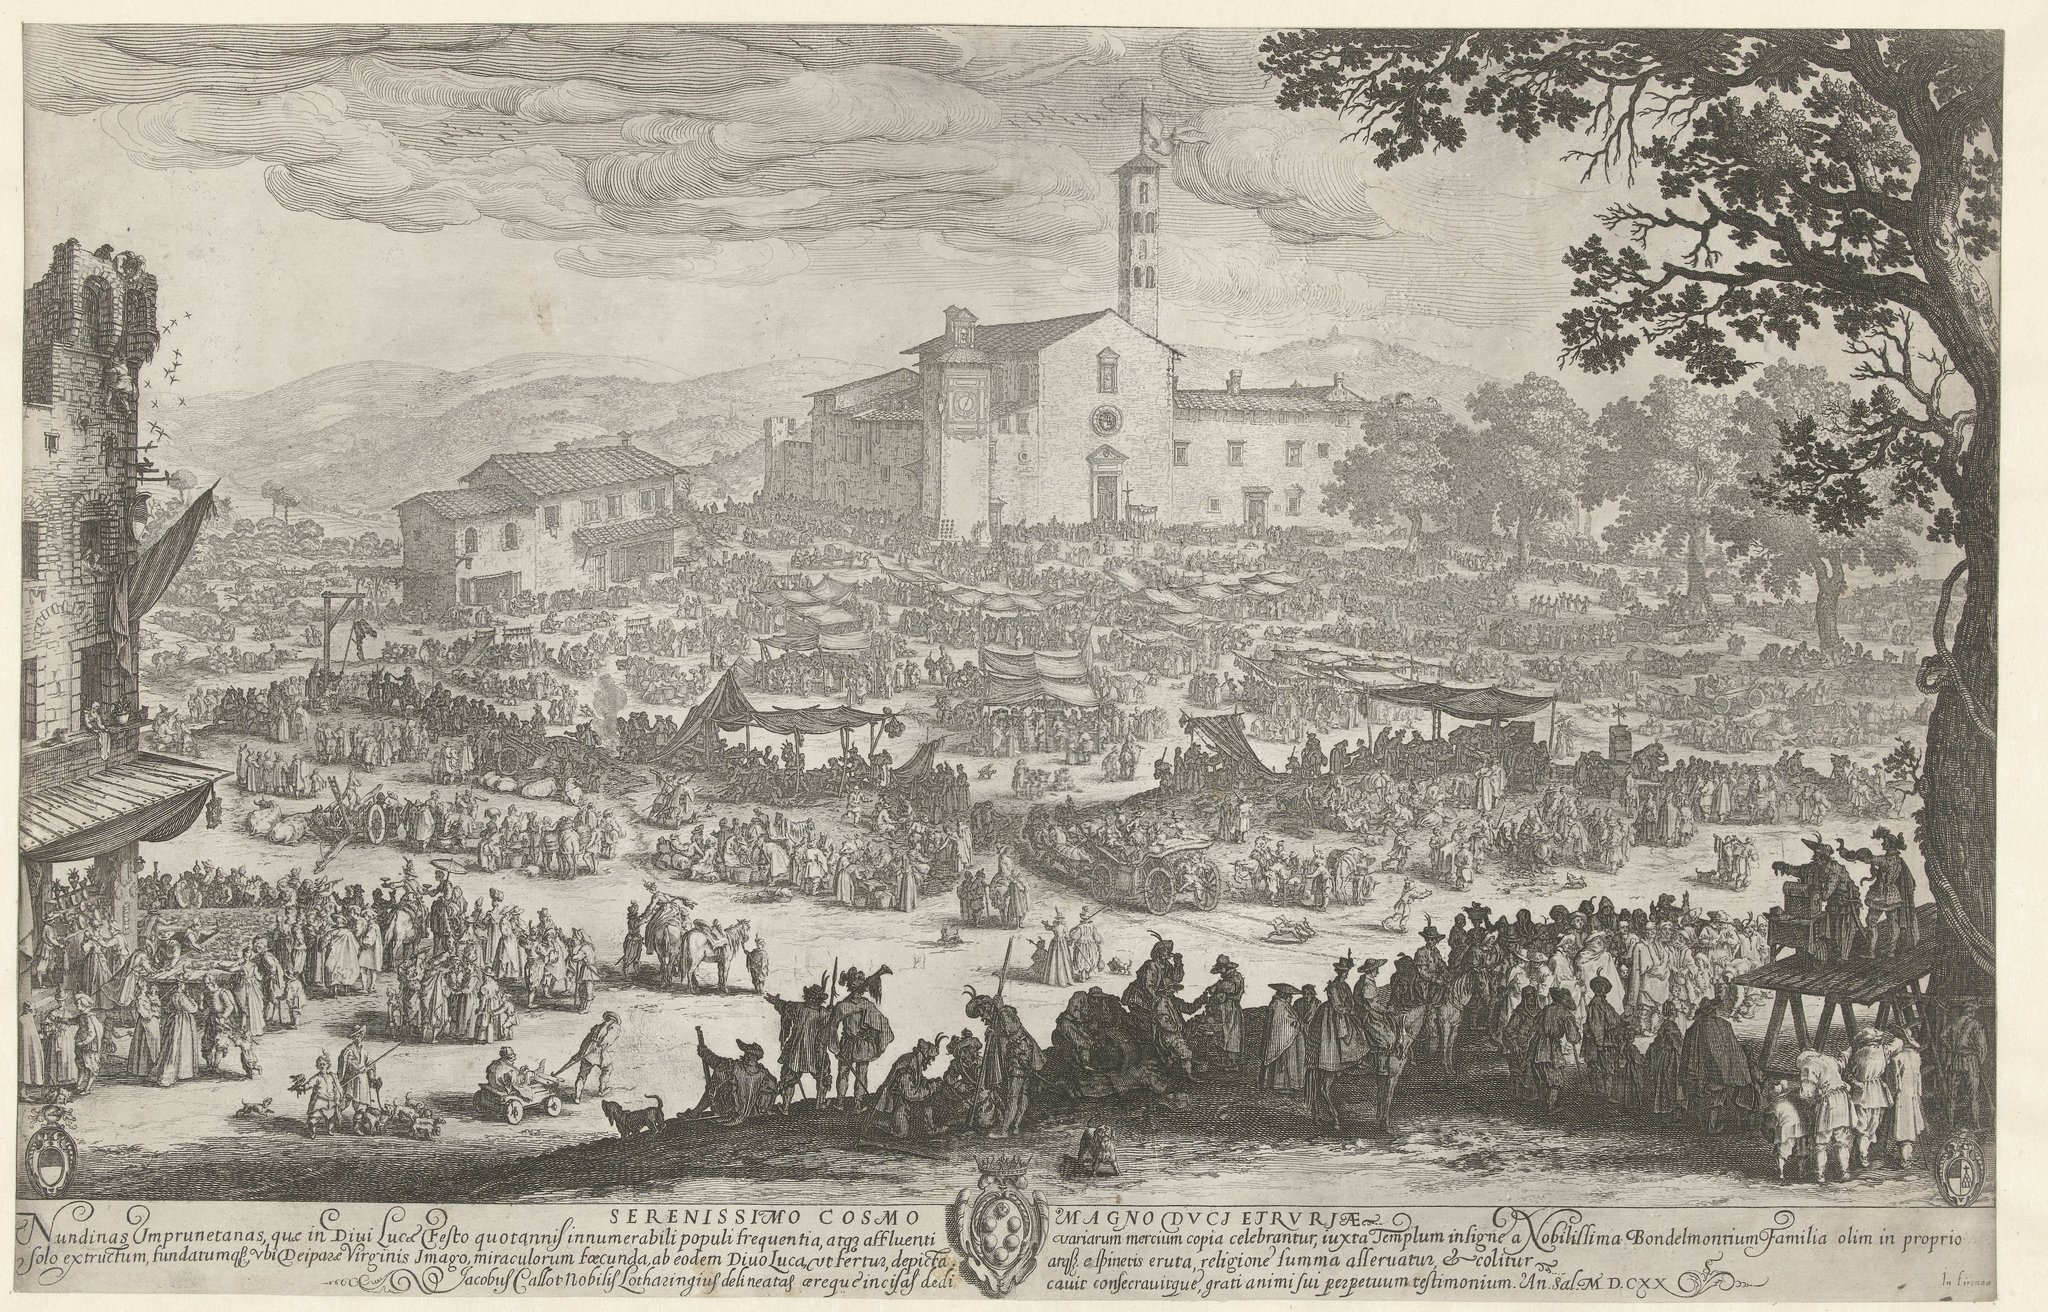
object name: print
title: Jaarmarkt te Impruneta nabij Florence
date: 1620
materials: paper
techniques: etching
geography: florence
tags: cosimo ii de' medici, (annual) fair, trade fair, village square, place, armorial bearing, heraldry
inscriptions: inscription: ‘Fen :26: Aprill 1659 / Heninck [?]’, collector's mark: Lugt 240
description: Jaarmarkt op 18 oktober te Impruneta, een dorp nabij Florence: een grote menigte kraampjes, handelaren en bezoekers op een plein voor een kerk. Linksonder het wapen van de Santa Mariakerk te Impruneta, rechtsonder het wapen van de familie Buondelmonti (die de kerk stichtte), middenonder het wapen van de Medici. Onder de voorstelling een onderschrift in Latijn.